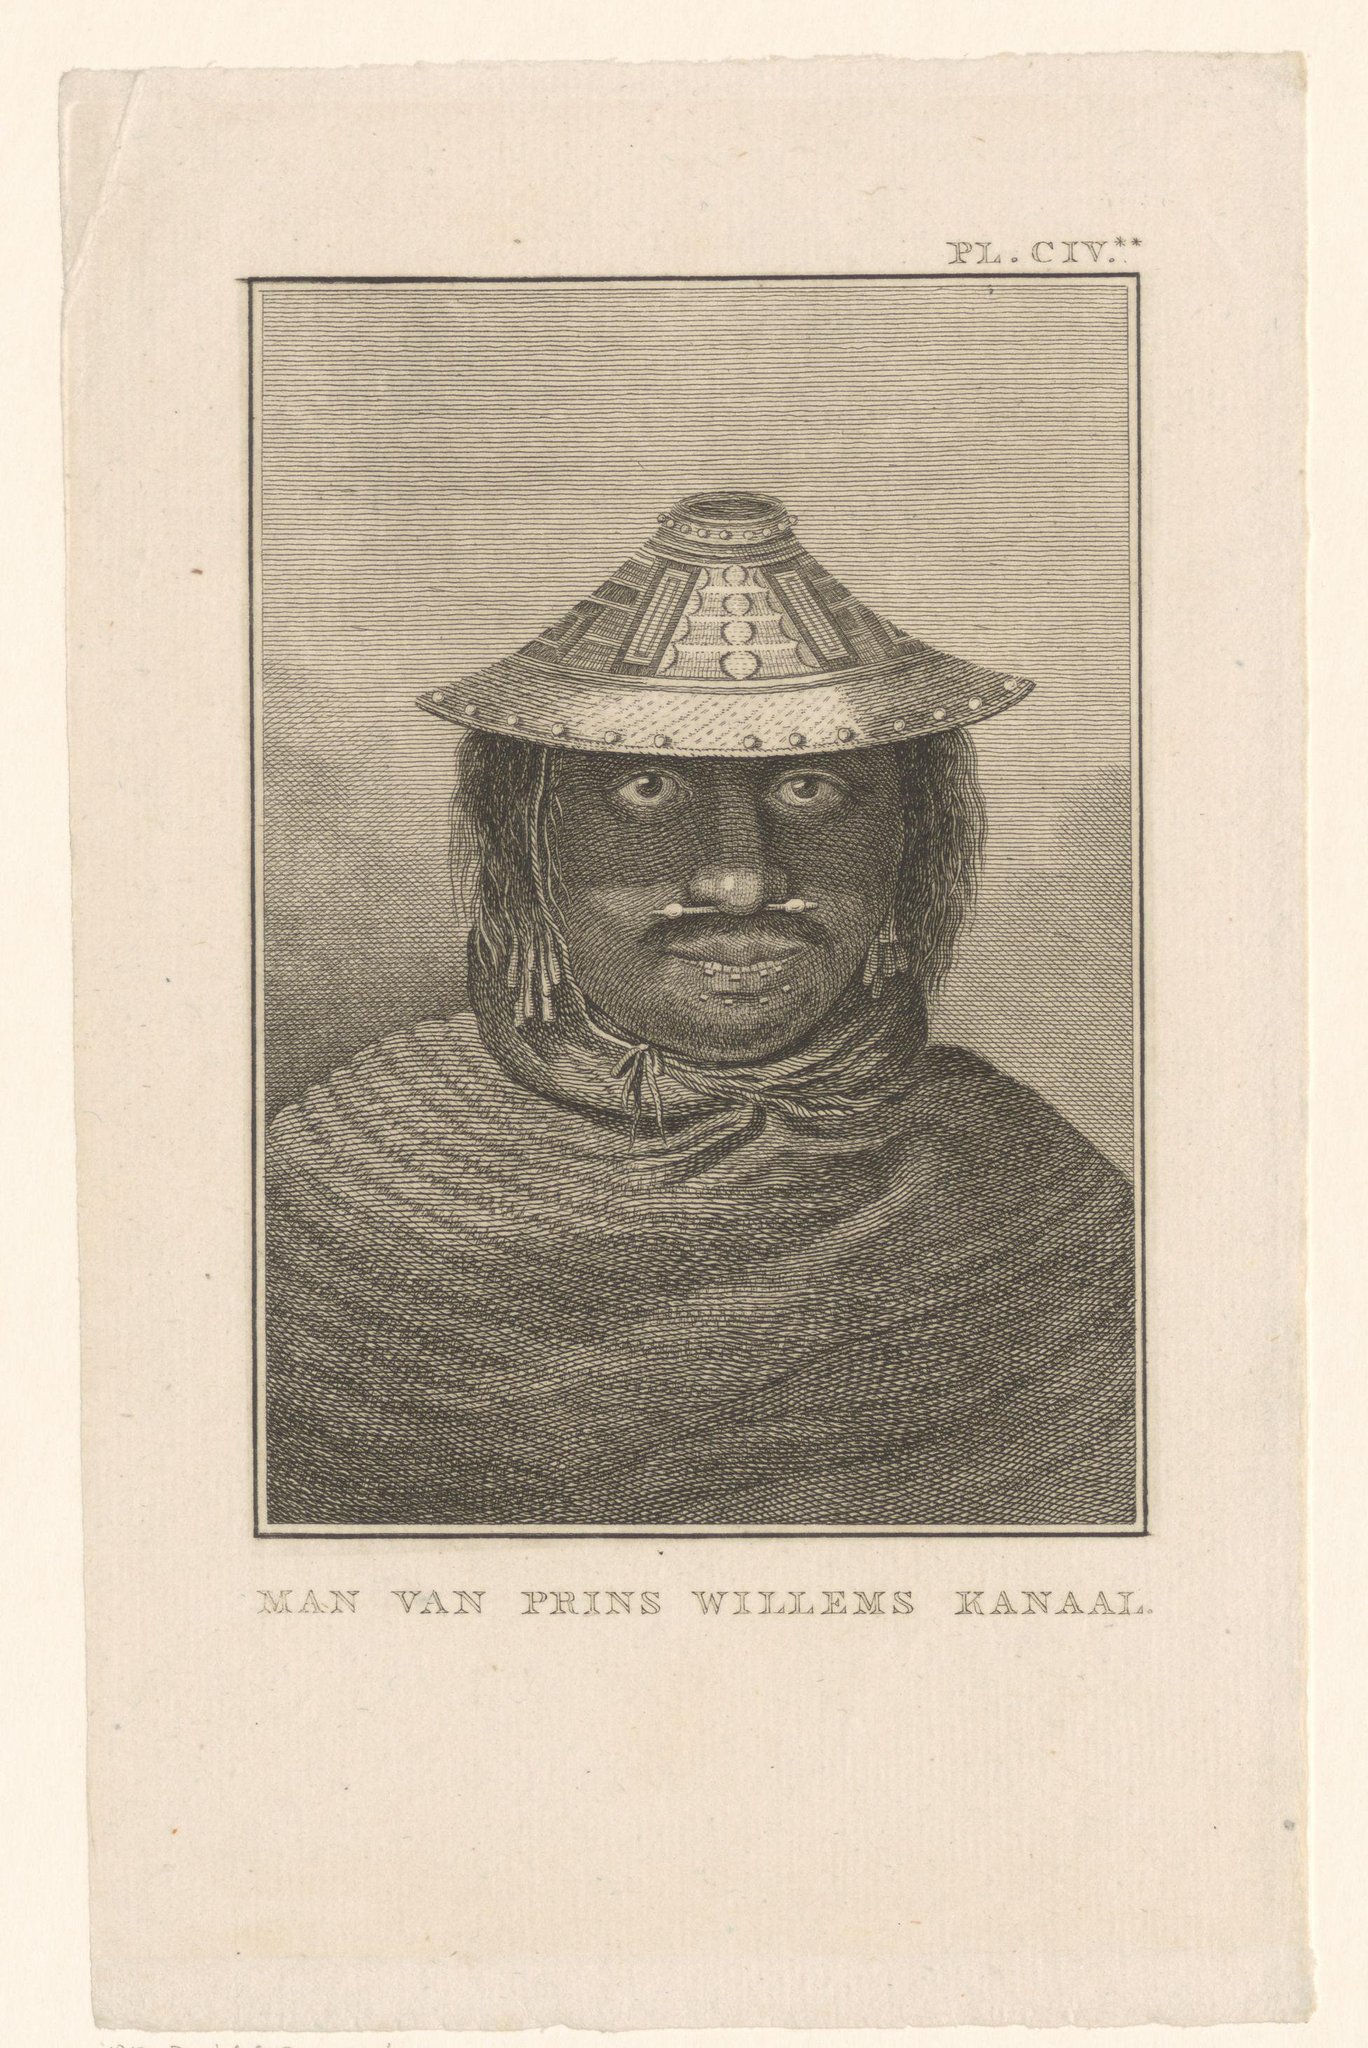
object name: print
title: Portret van een onbekende man afkomstig van het Prins Willems-eiland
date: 1795-1803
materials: paper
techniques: engraving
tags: adult man, anonymous historical person portrayed, folk costume, regional costume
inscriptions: number: ‘CIV’, collector's mark: Lugt 2228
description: De prent is gebruikt in: Cook, James. Reize rondom de Waereld (...) met kaarten en plaaten. [Vertaald uit het Engels door] Jan David Pasteur. Leiden: Honkoop, Amsterdam: Allart, Den Haag: Van Cleef, 1795-1803, dl. 13.